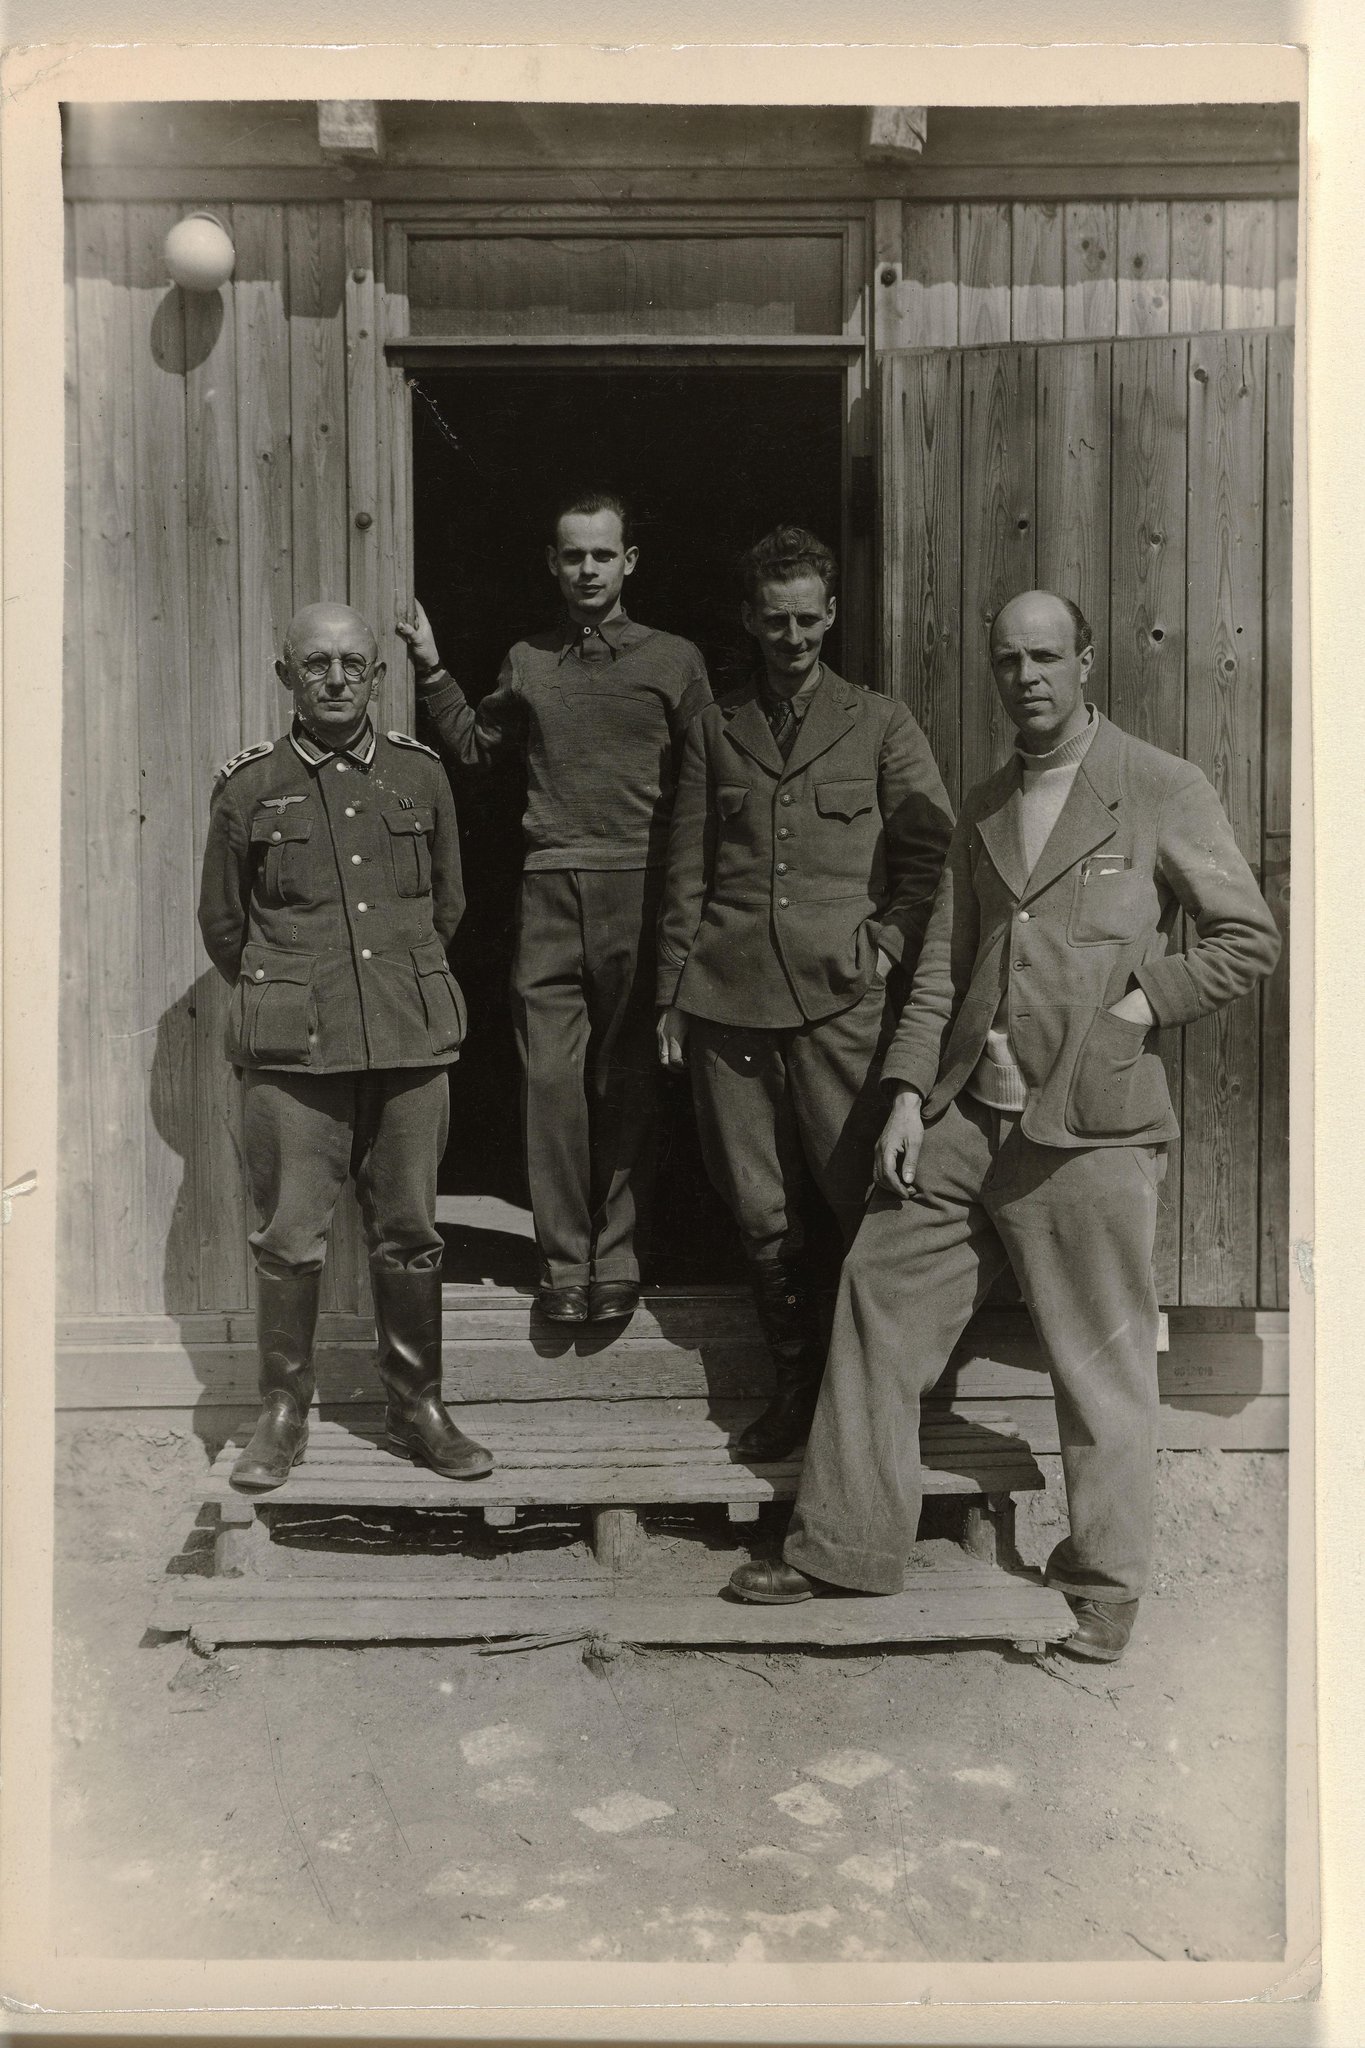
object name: photograph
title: Fotoafdeling aan het einde van de oorlog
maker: dick w.b. van maarseveen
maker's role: fotograaf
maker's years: 1905-1990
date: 1945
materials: photographic support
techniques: gelatin silver print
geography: muhlberg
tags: the hague, dick w.b. van maarseveen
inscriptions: workshop stamp: ‘Foto D. van Maarseveen Bezuidenhoutseweg 78 Telefoon 83 80 22 Den Haag’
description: Fotograaf Dick van Maarseveen poseert voor de deur van de barak waar het fotoatelier was met een Franse en een Duitse fotograaf. De Duitse onderofficier links had de leiding. Onderdeel van een groep foto's gemaakt door Dick van Maarseveen in het Duitse krijgsgevangenenkamp Stalag IV B in Mühlberg in de periode 1943-1945.